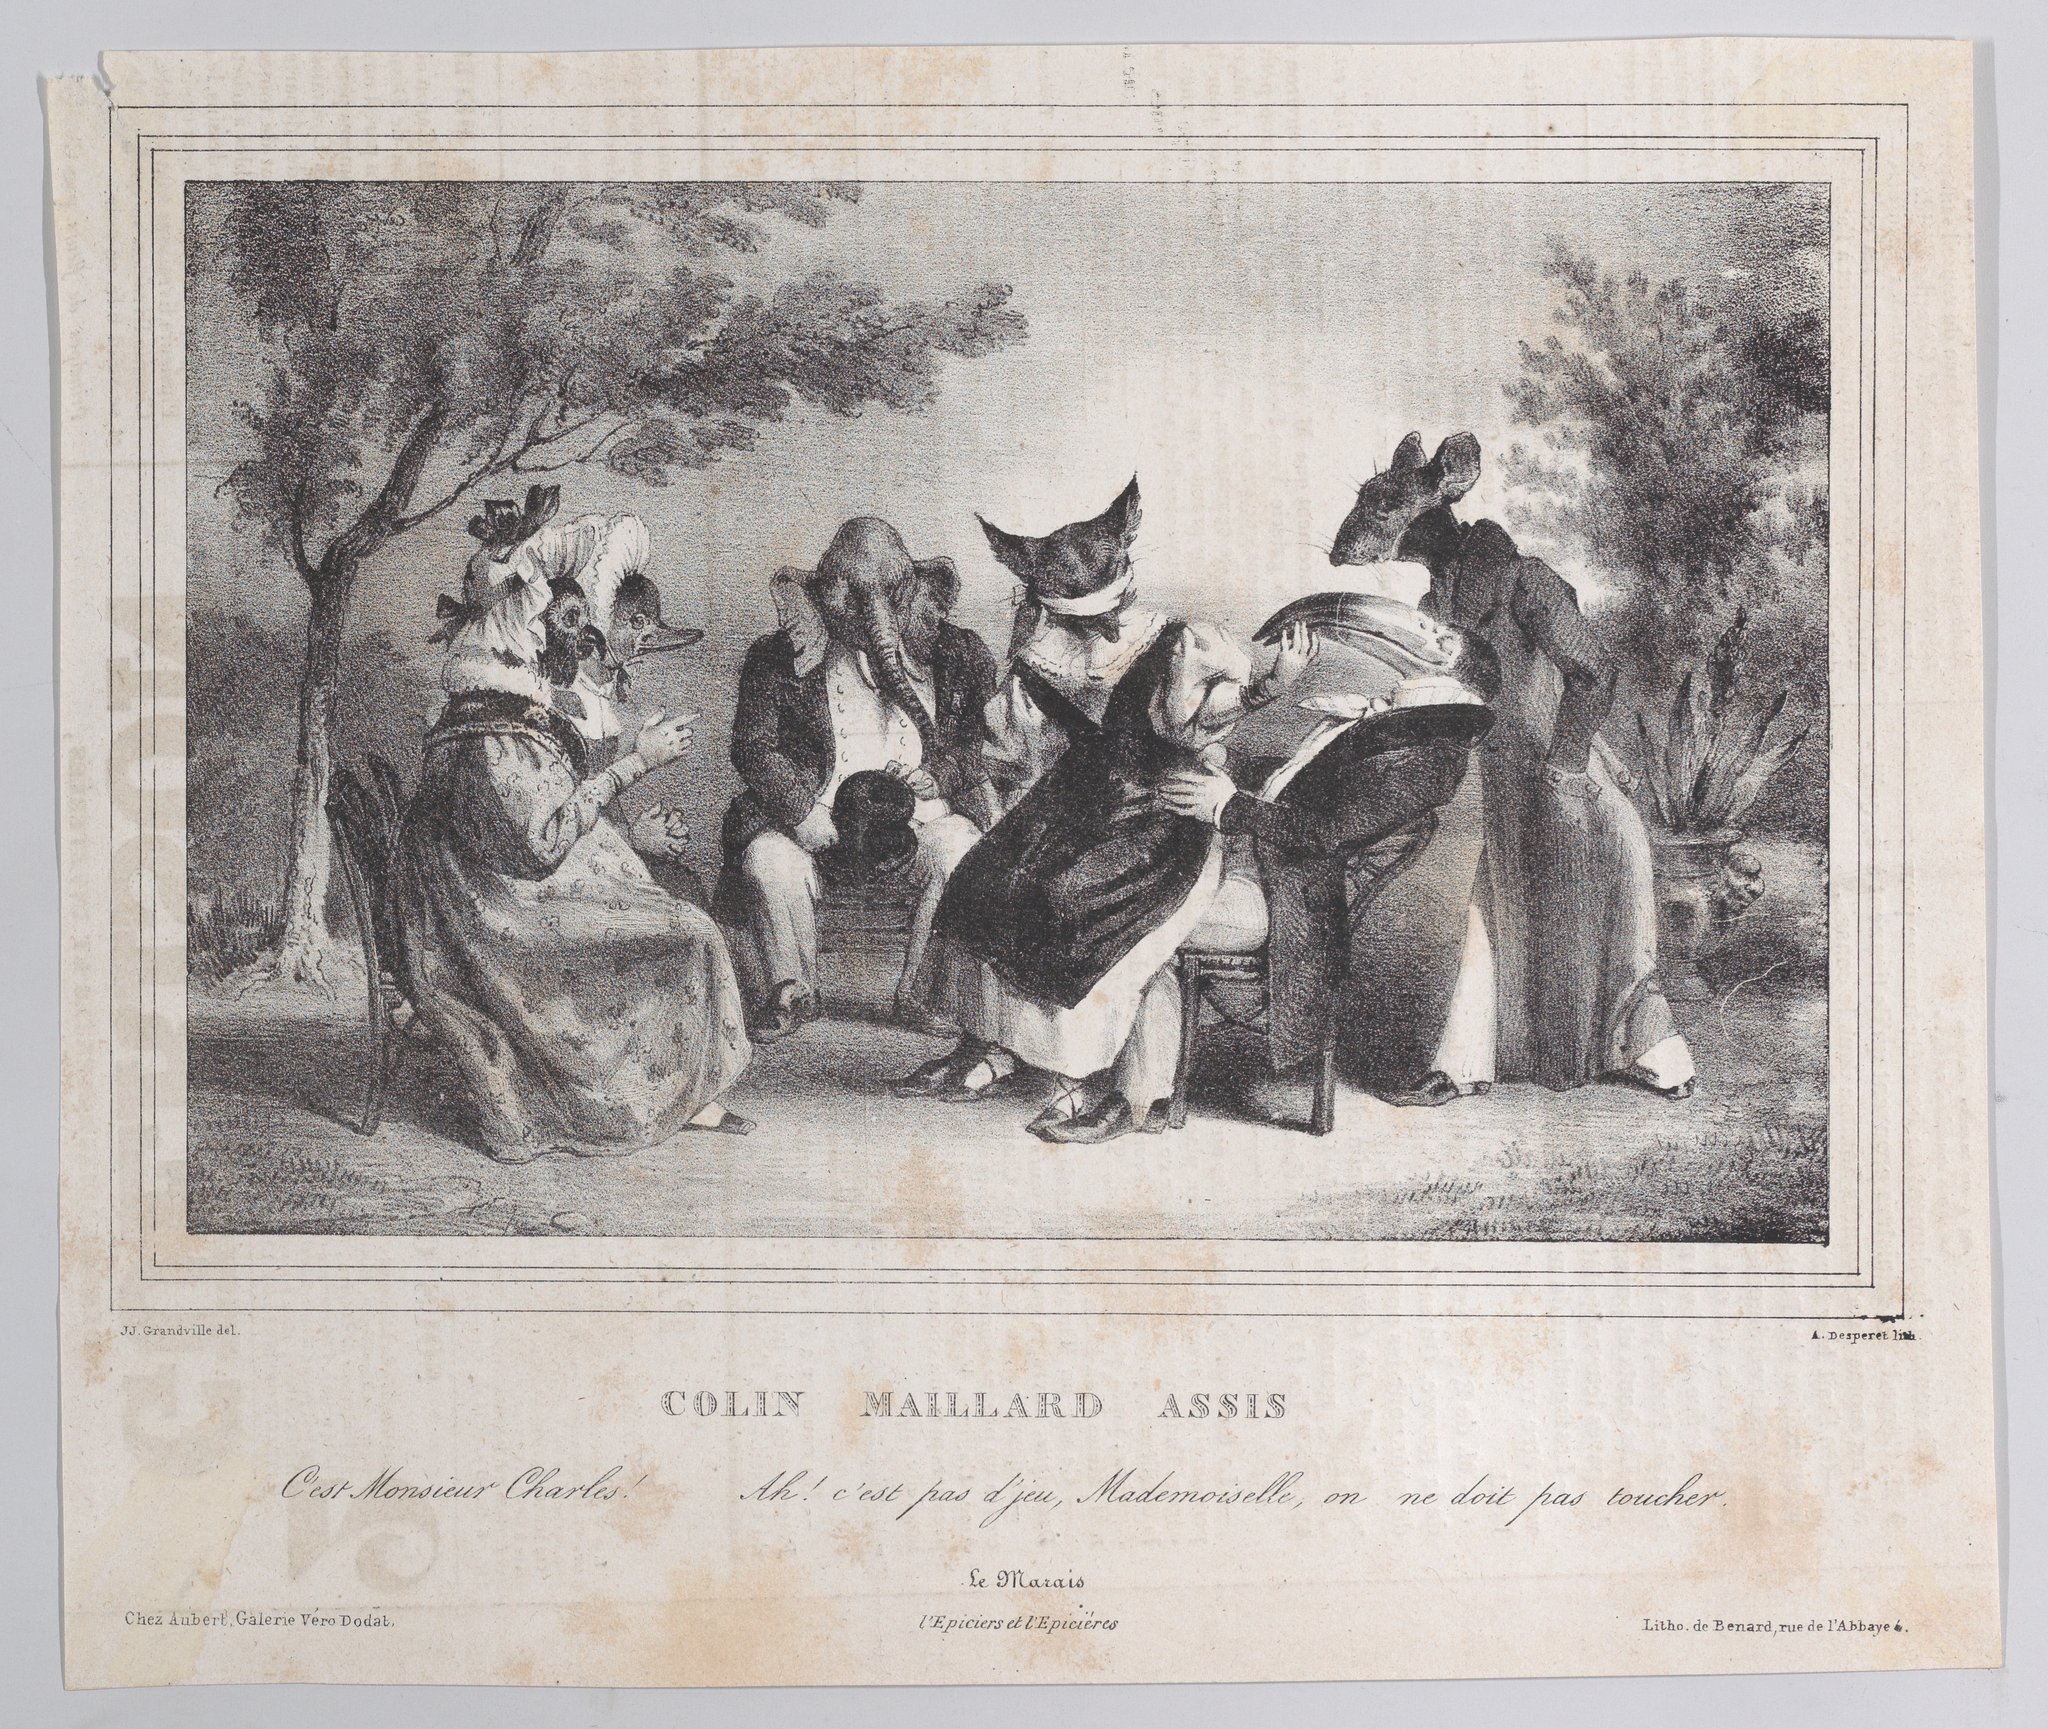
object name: print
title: The Moral and Picturesque Voyage of Prince Kamchaka (No. 1)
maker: j. j. grandville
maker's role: designer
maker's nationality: french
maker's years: 1803-1847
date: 1839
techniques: lithograph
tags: birds,satire,elephants